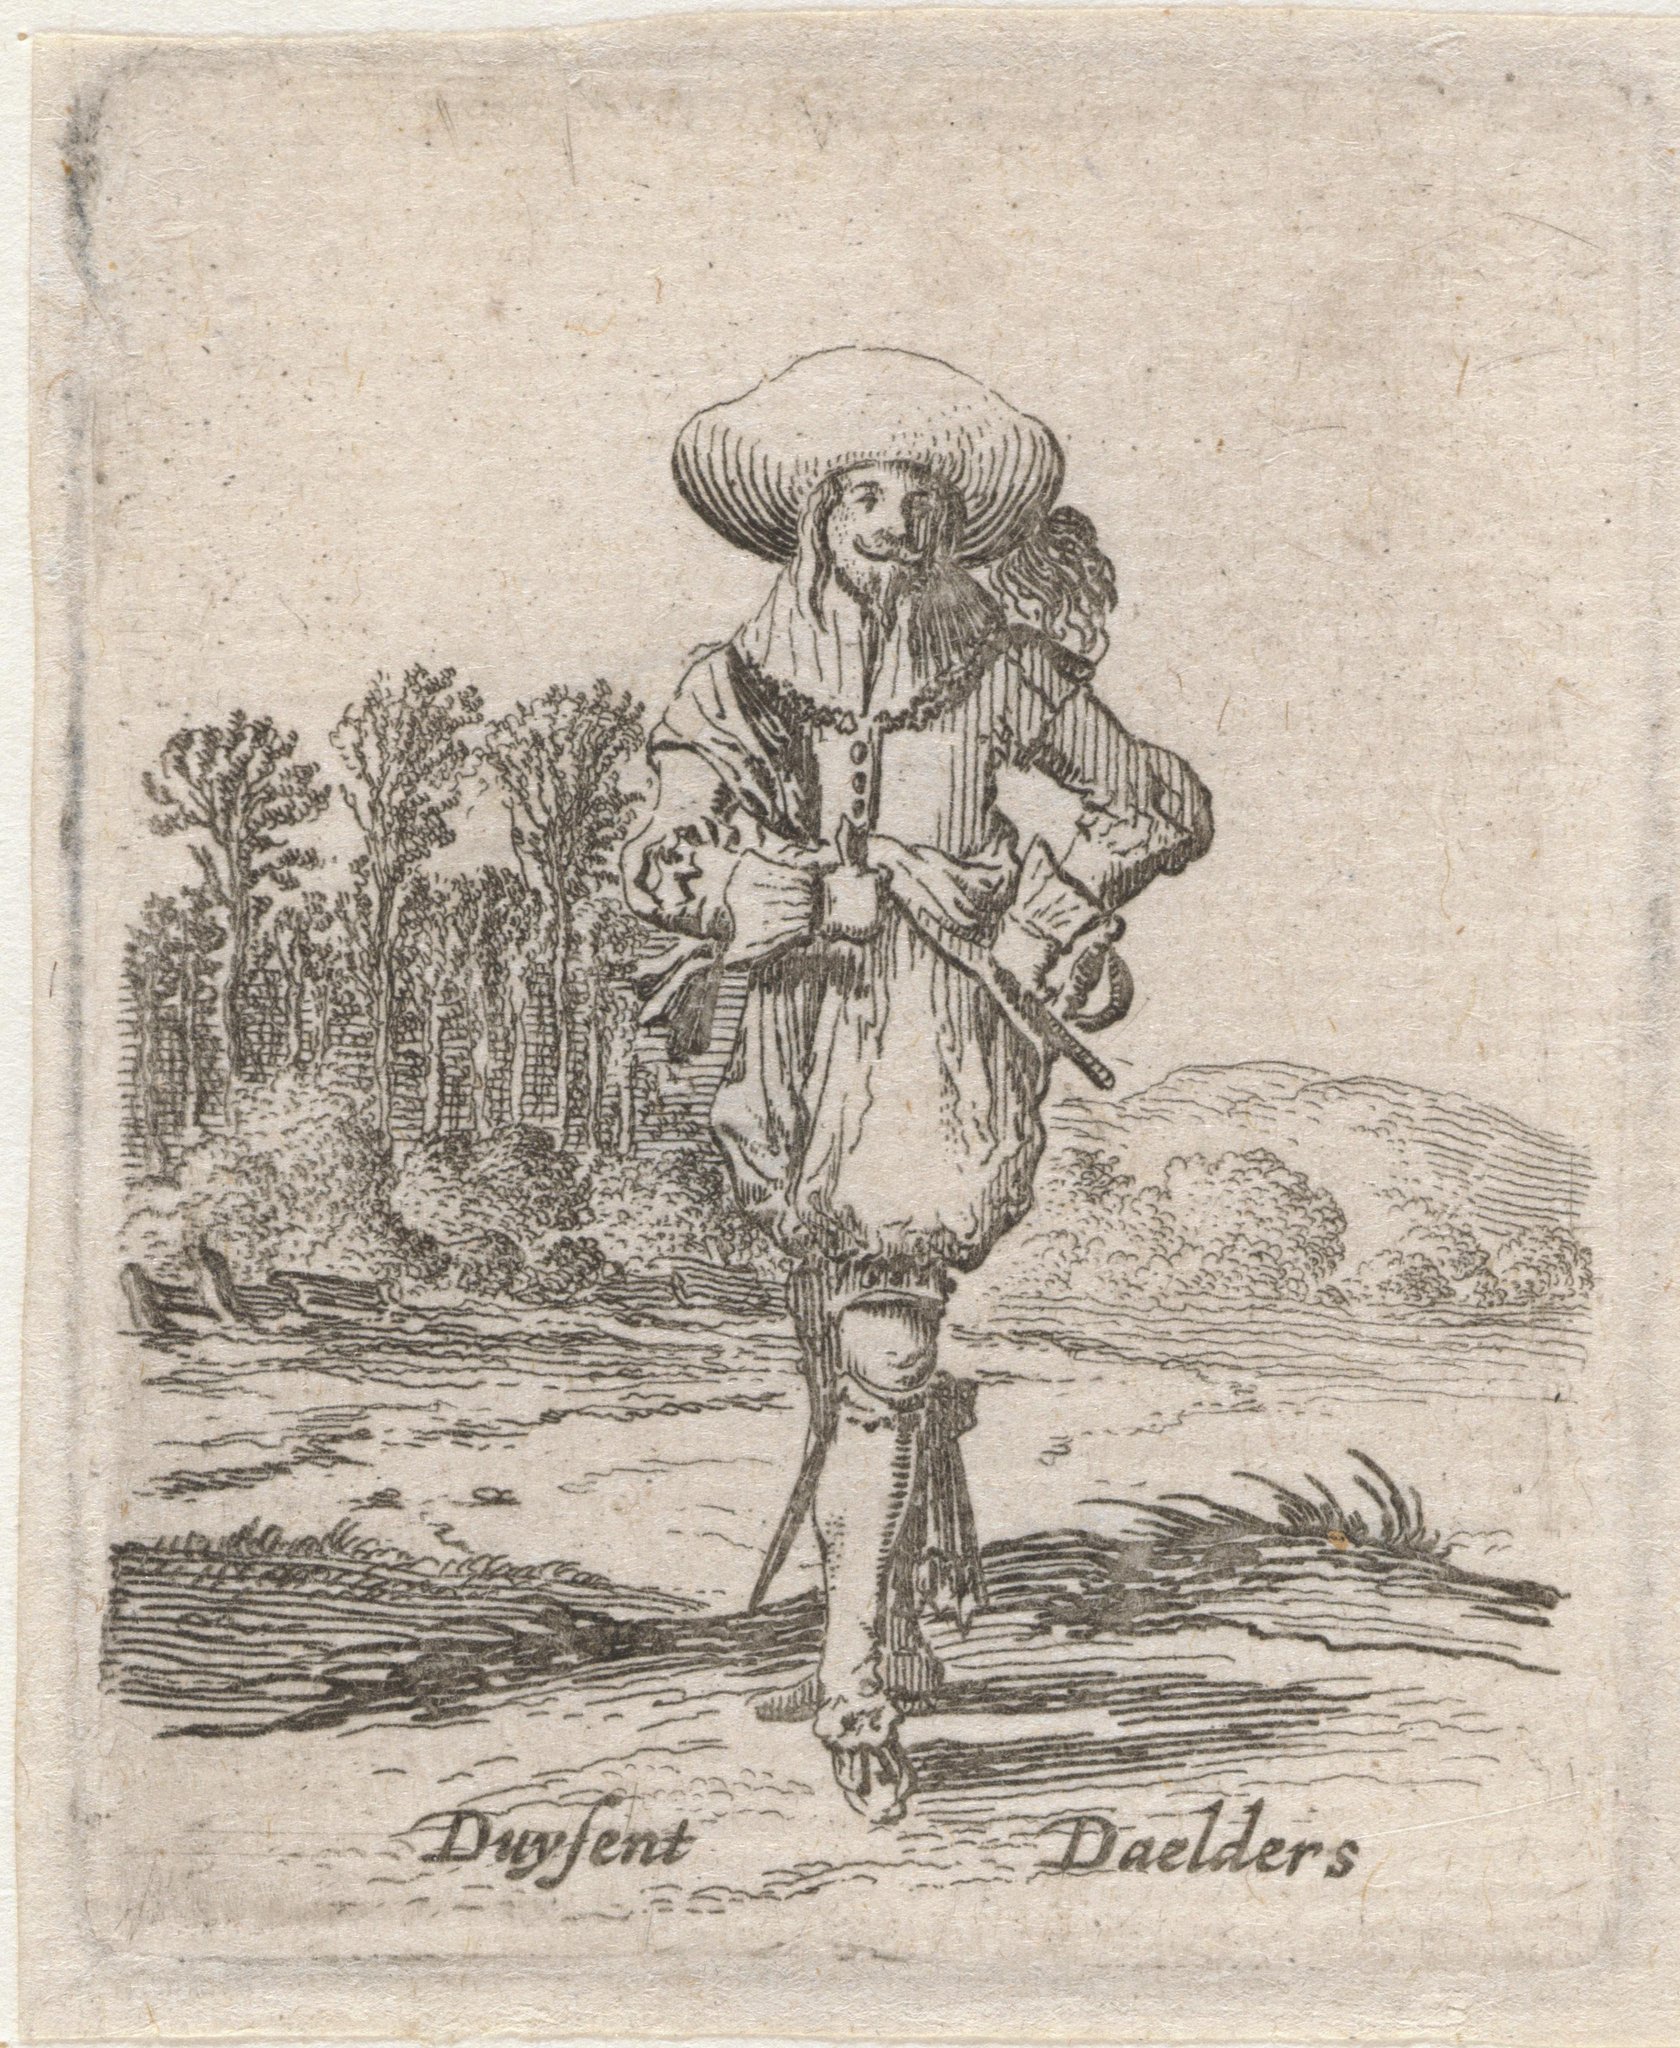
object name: print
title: Man met de handen in de zij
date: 1638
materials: paper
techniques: etching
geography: amsterdam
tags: head-gear: hat (+ men's clothes)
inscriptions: collector's mark: Lugt 2760, collector's mark: Lugt 2228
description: Een man met een gevederde hoed op het hoofd en de handen in de zij. Op de achtergrond enkele bomen. De prent maakt deel uit van een serie van 32 prenten met genretaferelen.